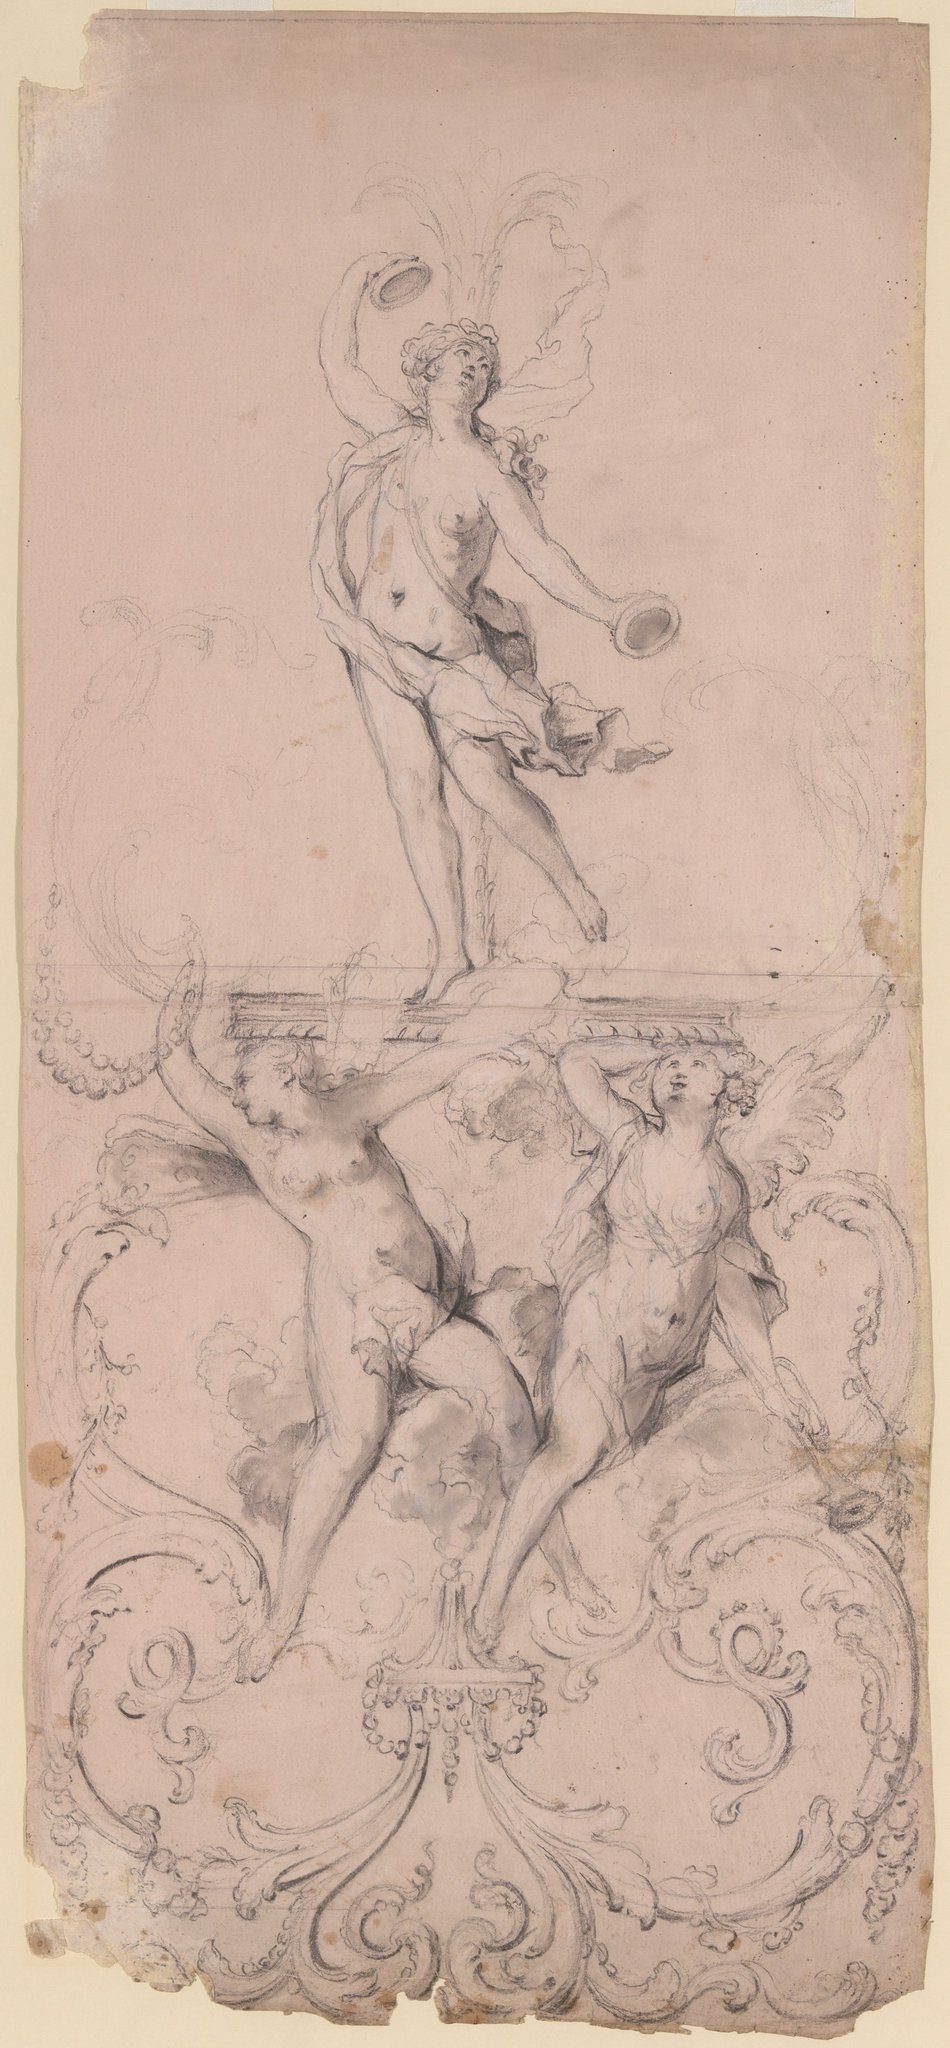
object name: drawing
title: Ornament Design with Three Nymphs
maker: anonymous, french, 19th century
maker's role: artist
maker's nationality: french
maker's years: 1800-1900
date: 1801-1900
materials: chalk, graphite, paper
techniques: heightening, stumping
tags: ornament,nymphs